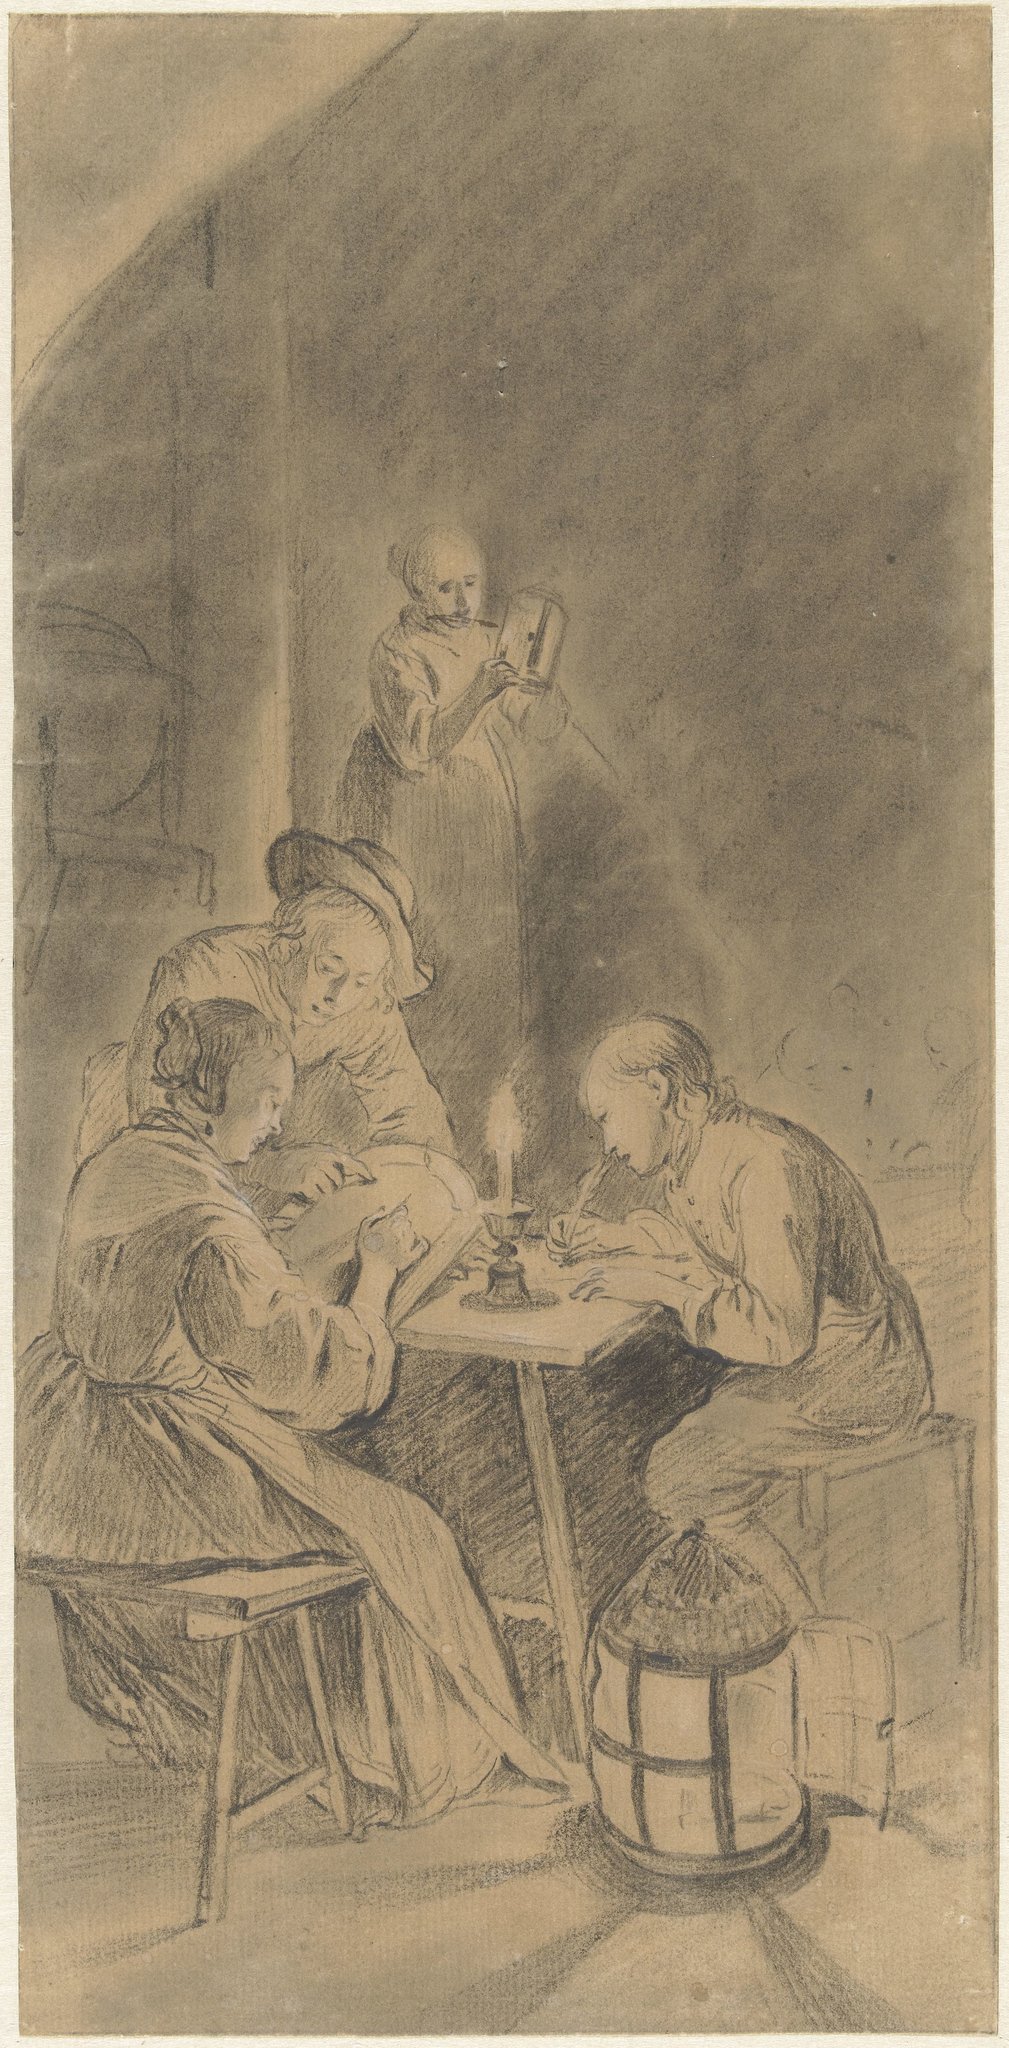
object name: drawing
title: Onderwijs bij kaarslicht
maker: willem joseph laquy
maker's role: draughtsman, painter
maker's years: 1738-1798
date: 1765-1770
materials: chalk, paper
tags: scholastic education, tuition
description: Uit Drieluik met allegorie op het kunstonderwijs: onderwijs bij kaarslicht.